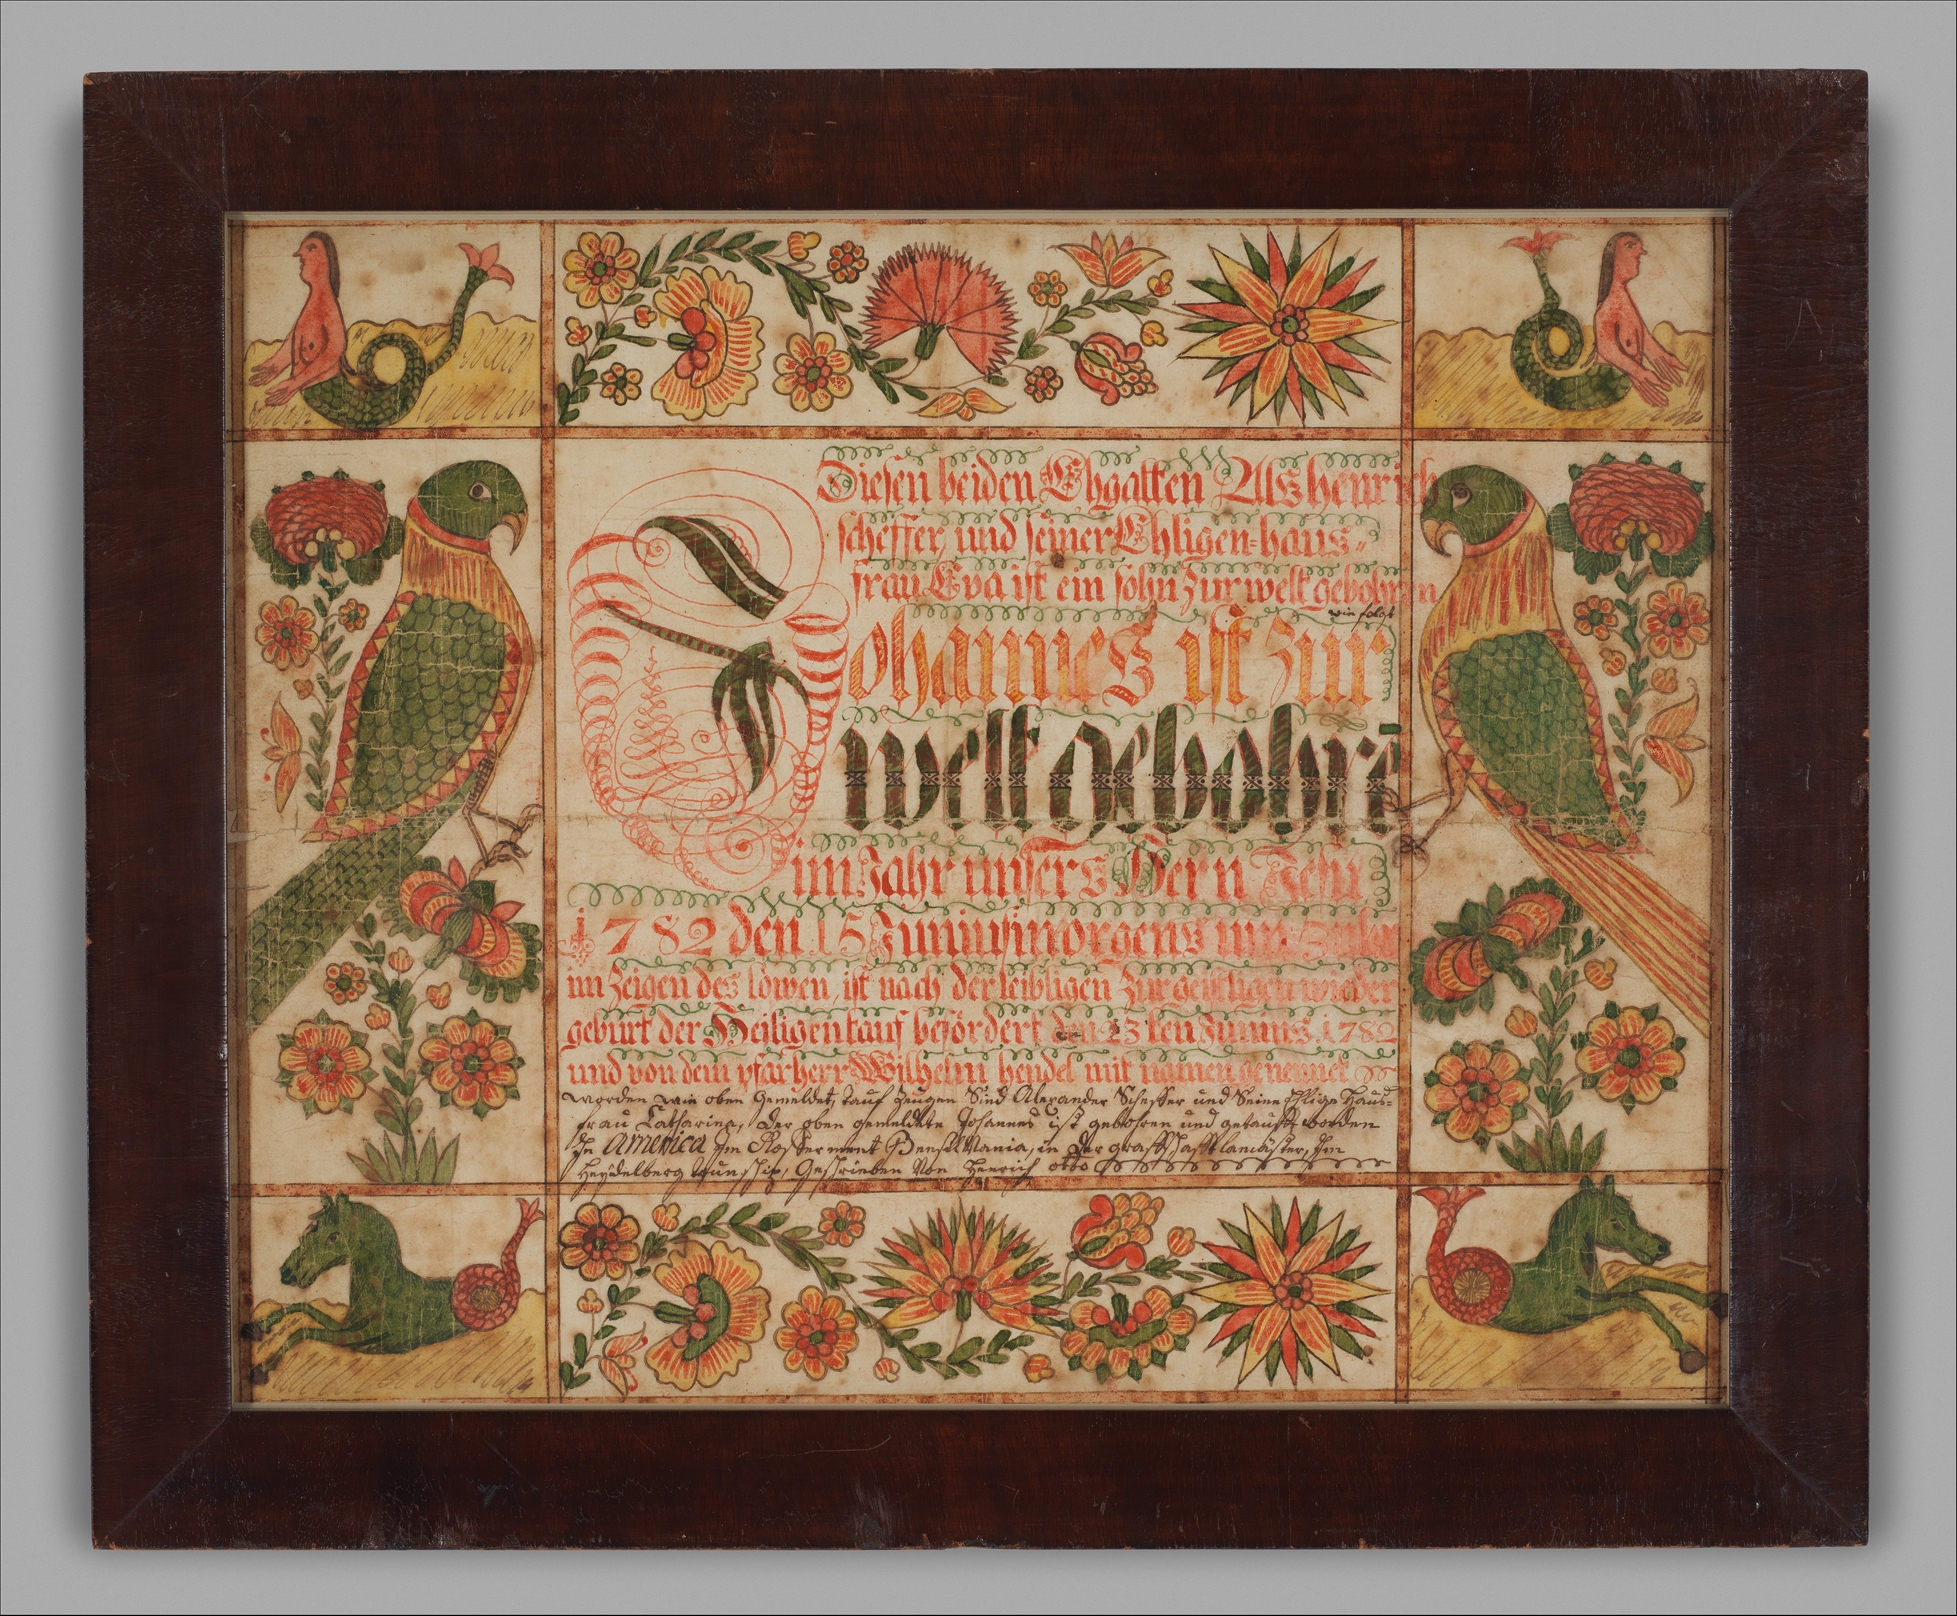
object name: birth and baptismal certificate, fraktur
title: Birth and Baptismal Certificate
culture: american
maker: johann heinrich otto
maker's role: maker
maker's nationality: american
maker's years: 1730-1800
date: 1782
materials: ink, paper, watercolor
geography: united states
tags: mythical creatures,parrots,flowers